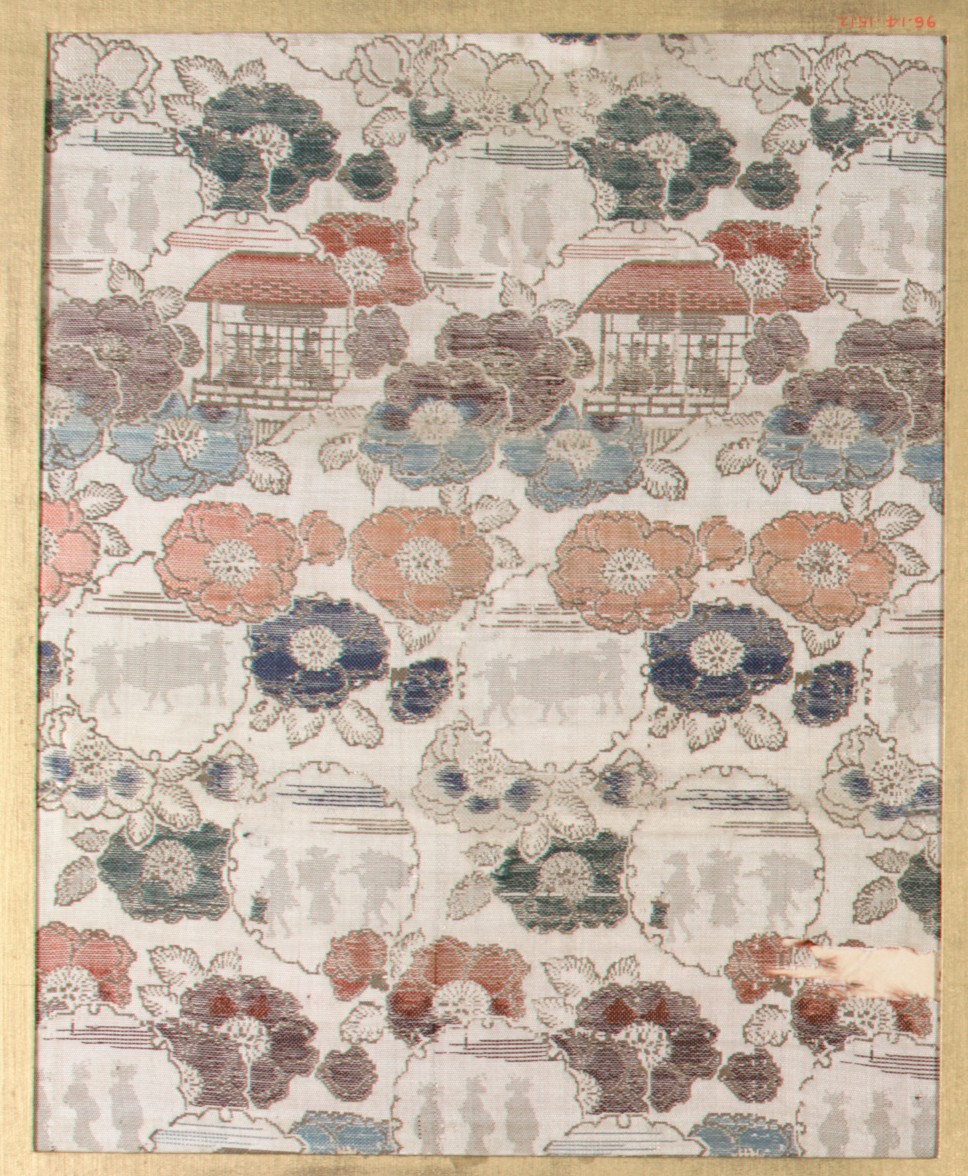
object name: piece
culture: japanese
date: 1701-1900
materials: silk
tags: flowers